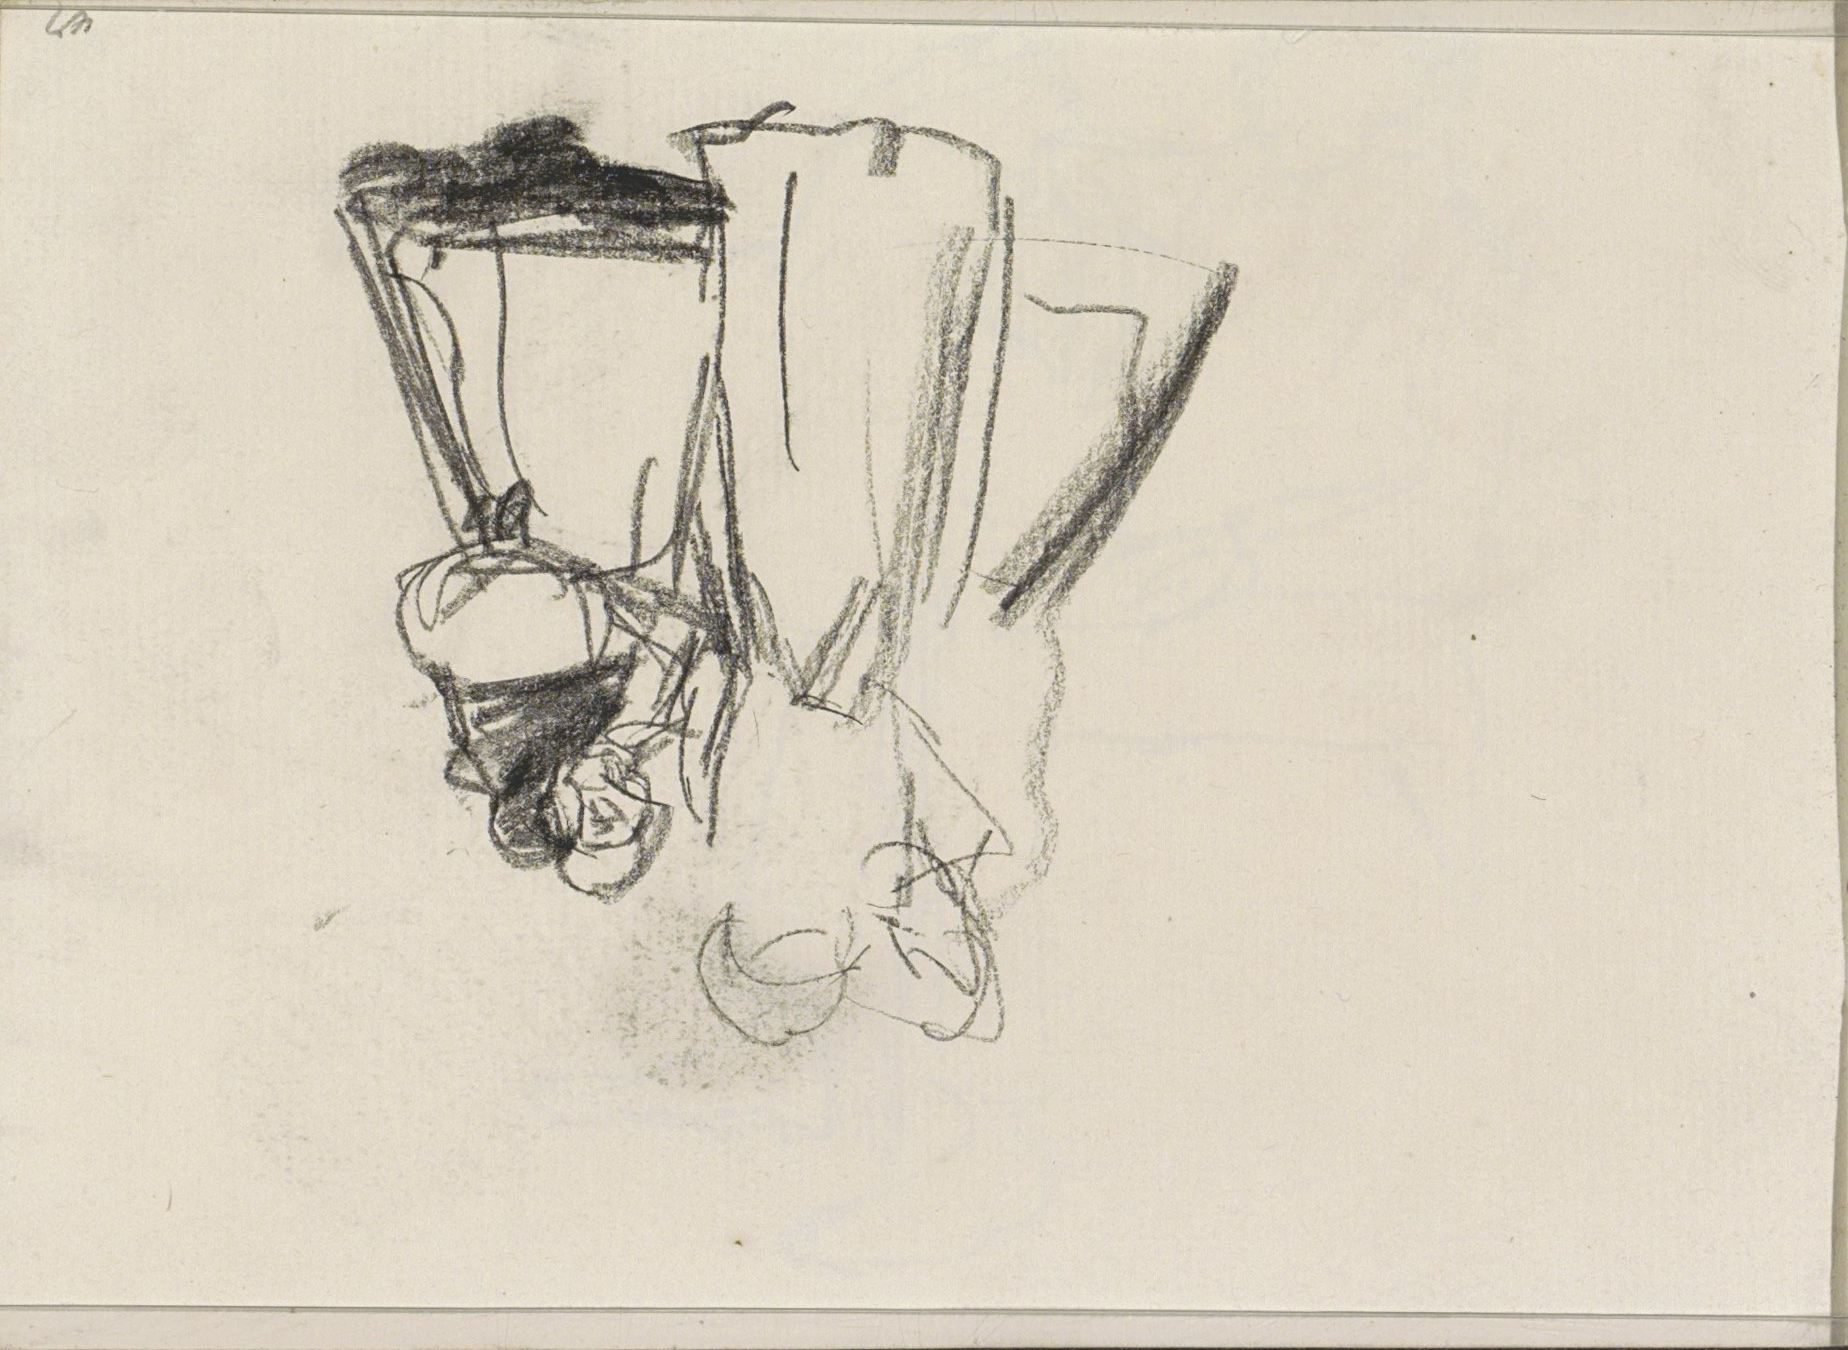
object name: sketchbook leaf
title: Drie staande vrouwen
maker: isaac israels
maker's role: draughtsman, painter, print maker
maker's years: 1865-1934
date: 1875-1934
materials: chalk, paper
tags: adult woman (+ standing)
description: Blad 6 verso uit schetsboek LVI met 26 bladen.